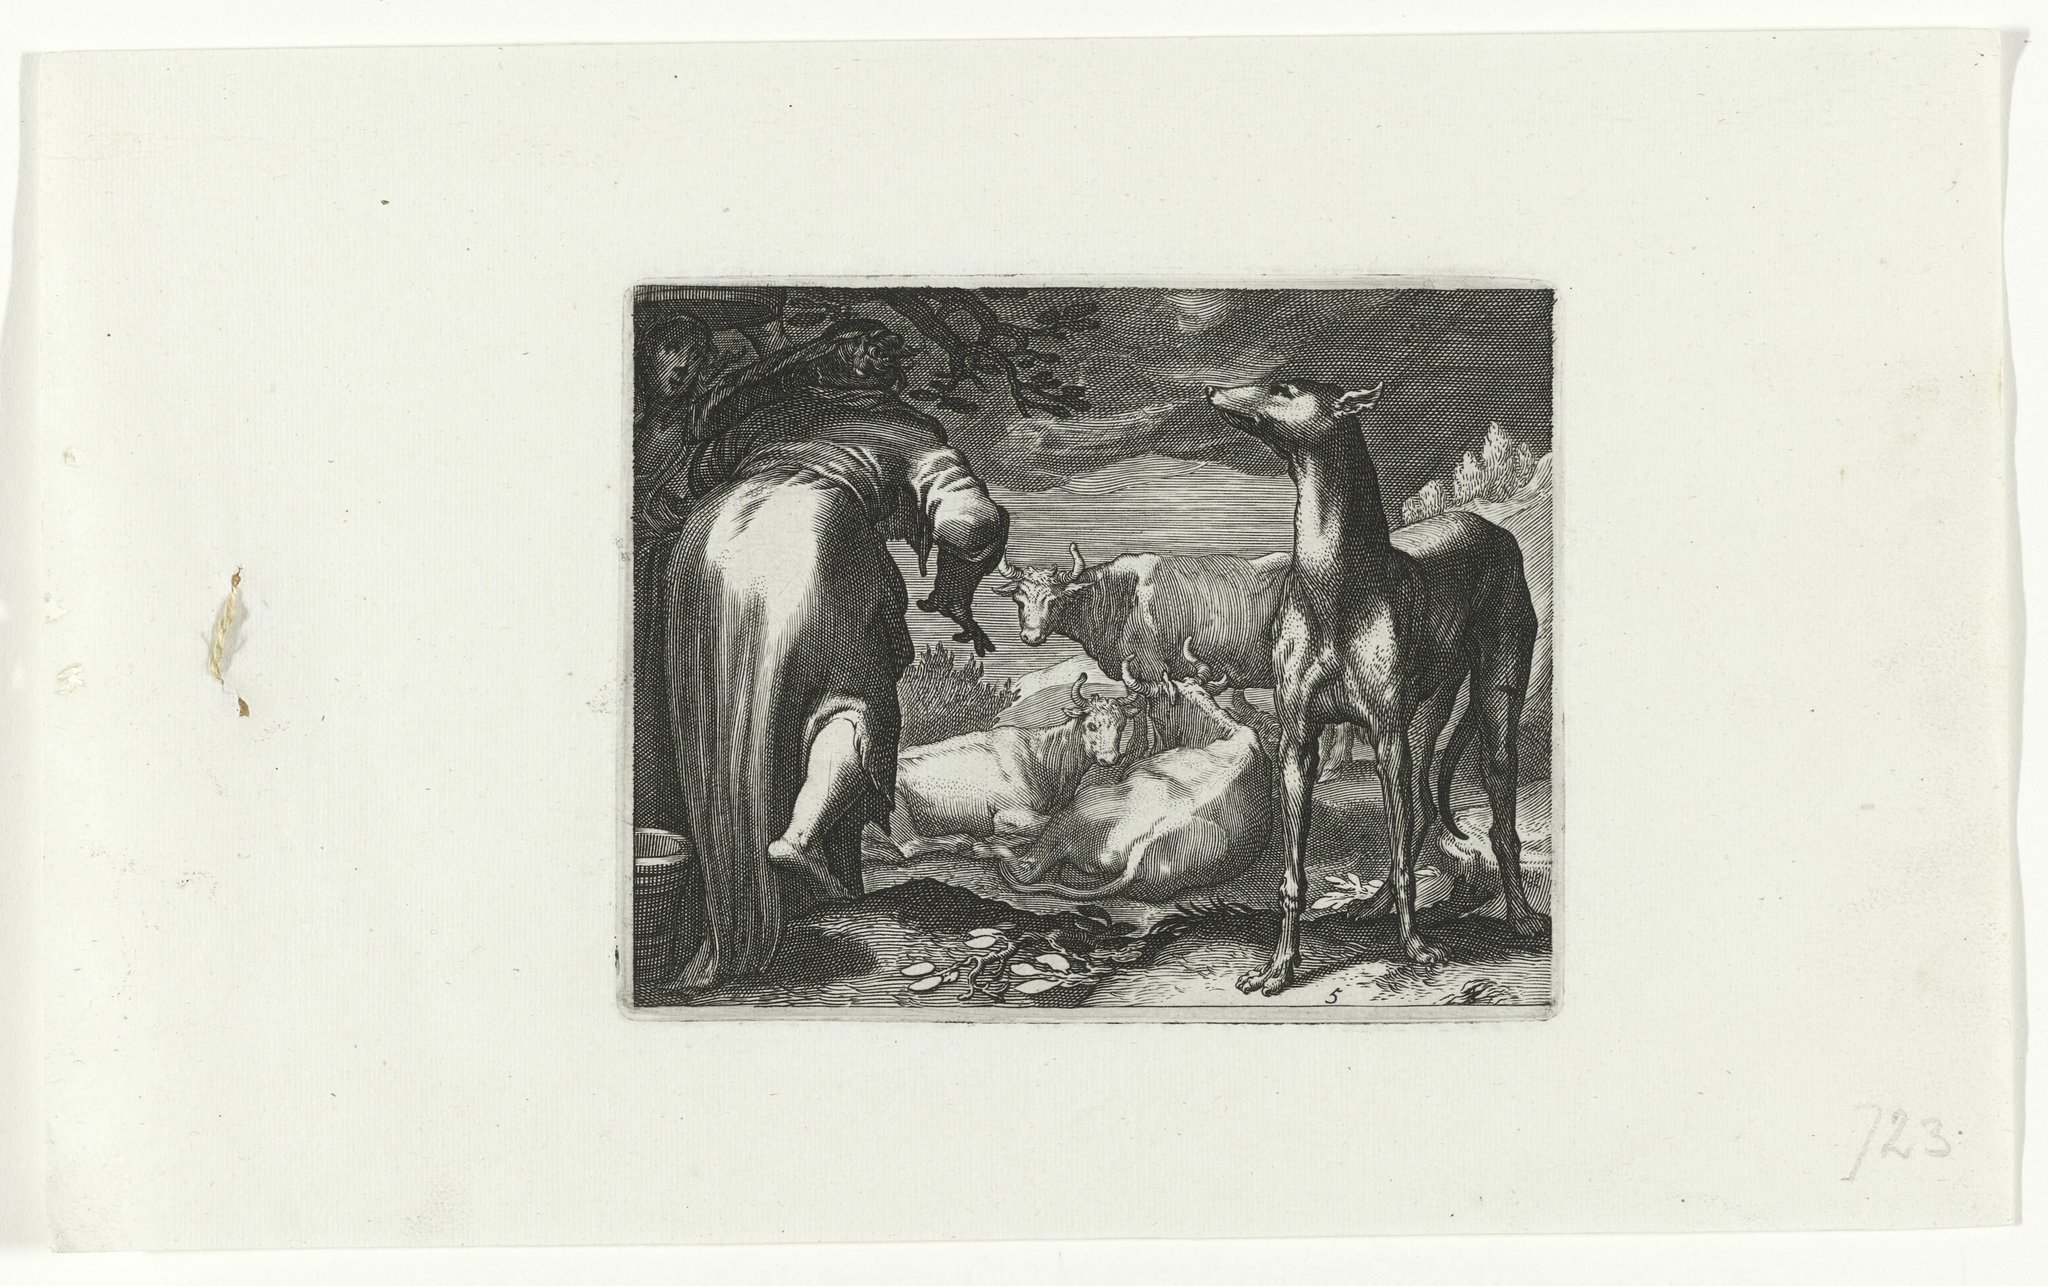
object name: print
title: Pastoralen en dieren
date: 1611-1650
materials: paper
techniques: engraving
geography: netherlands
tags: cow, milkmaid, dog